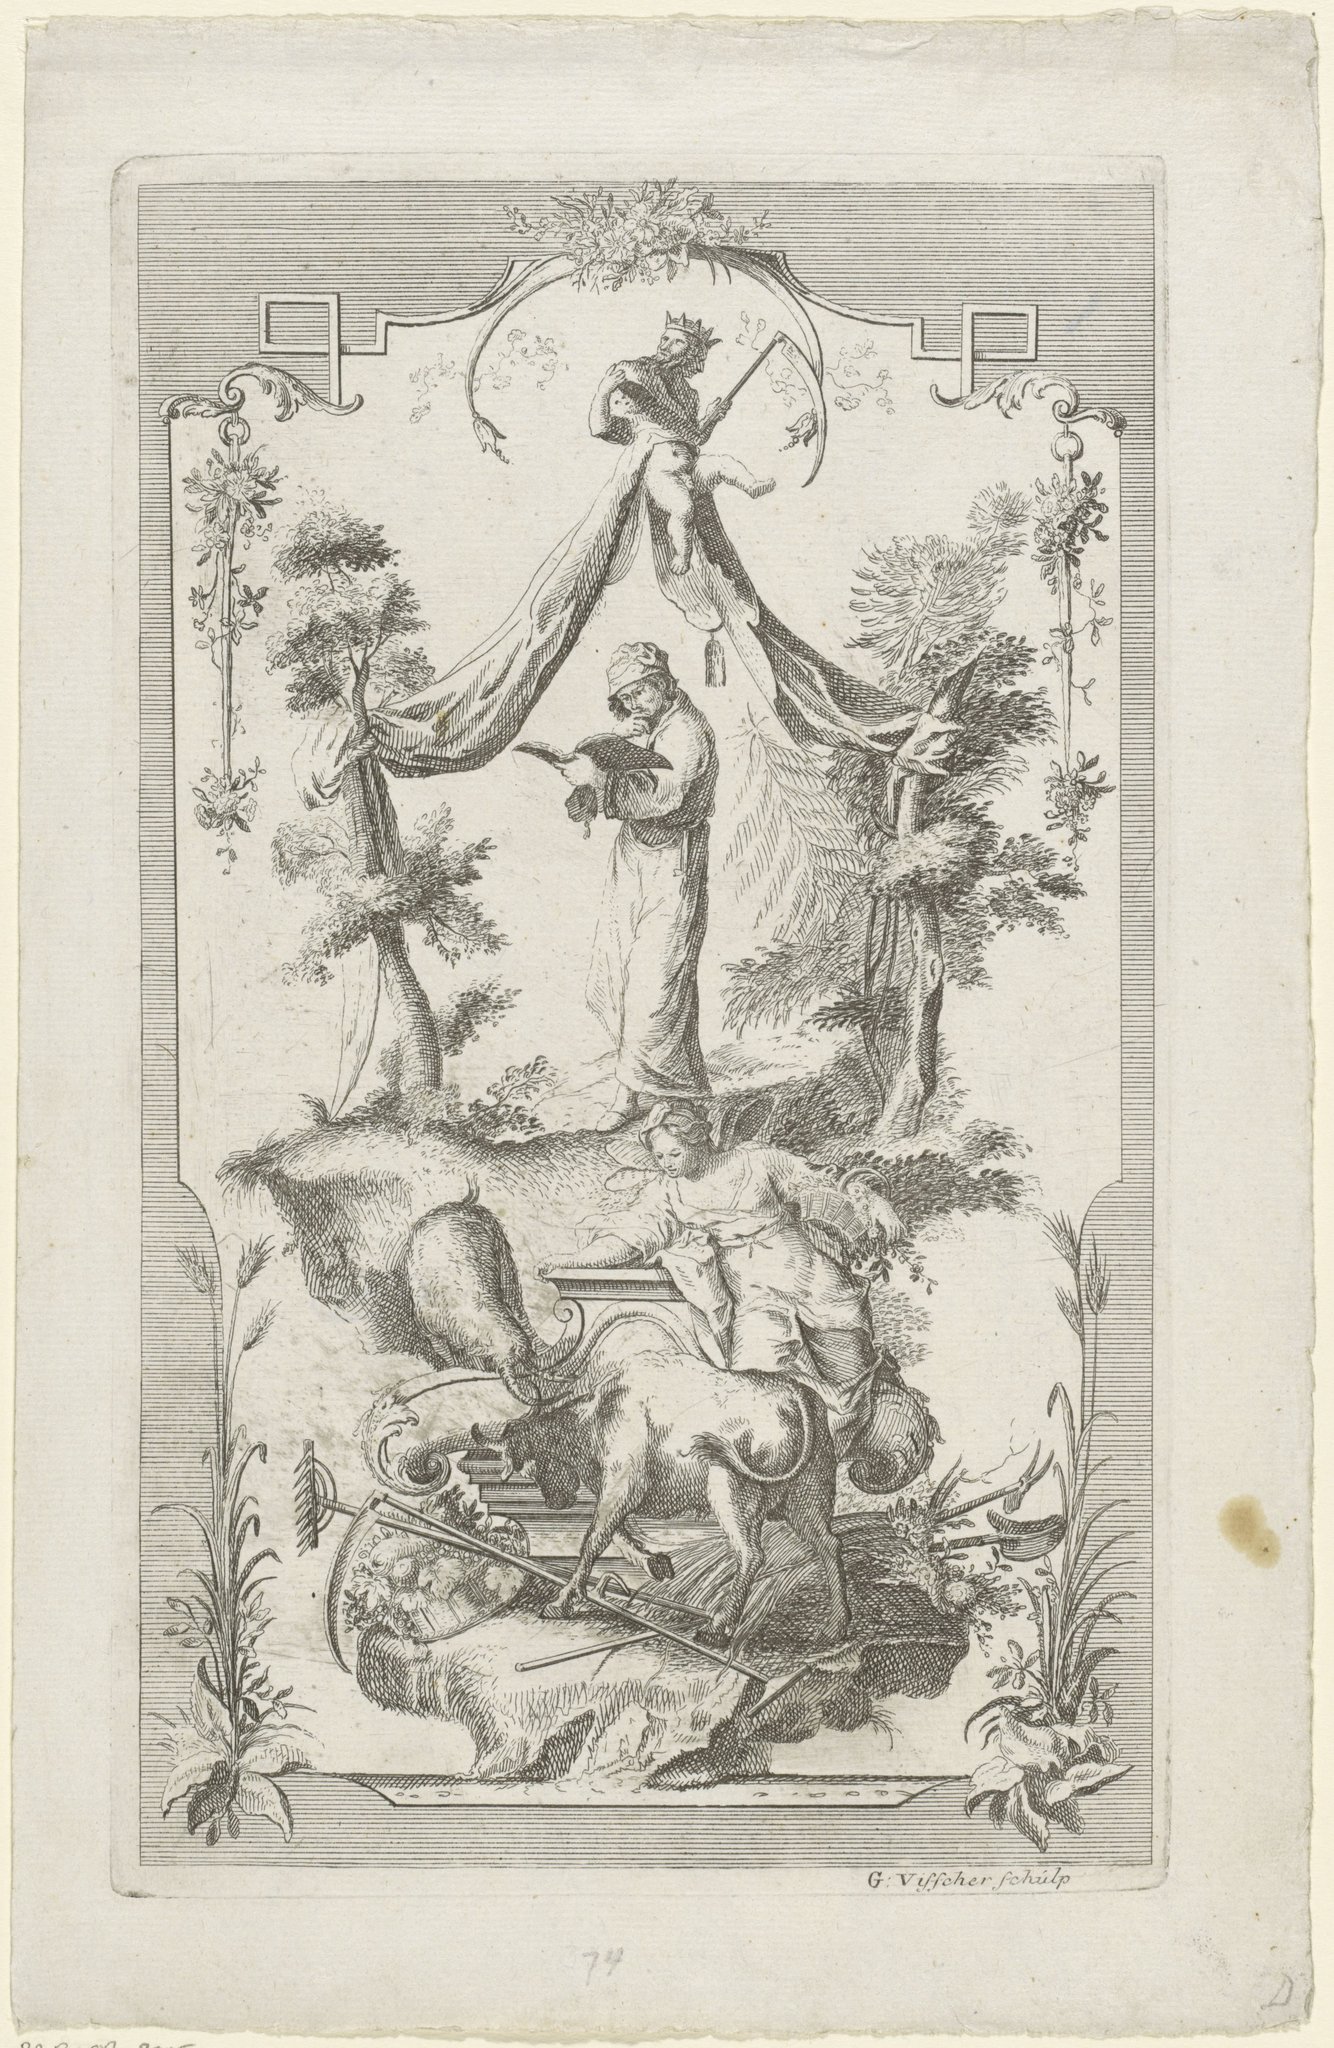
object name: ornament print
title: Man verdiept in boek en vrouw bij koe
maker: gerrit visscher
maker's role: print maker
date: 1690-1710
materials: paper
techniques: engraving, etching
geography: amsterdam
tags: ornaments ~ art, cow, reading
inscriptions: collector's mark: Lugt 2228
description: Centraal een staande man lezend in een boek. Daarboven een halffiguur met twee gezichten, een kroon op het hoofd, een baby onder de arm, en in de andere hand een zeis. Midden onder een vrouw leunend tegen een monument en daarbij een koe.